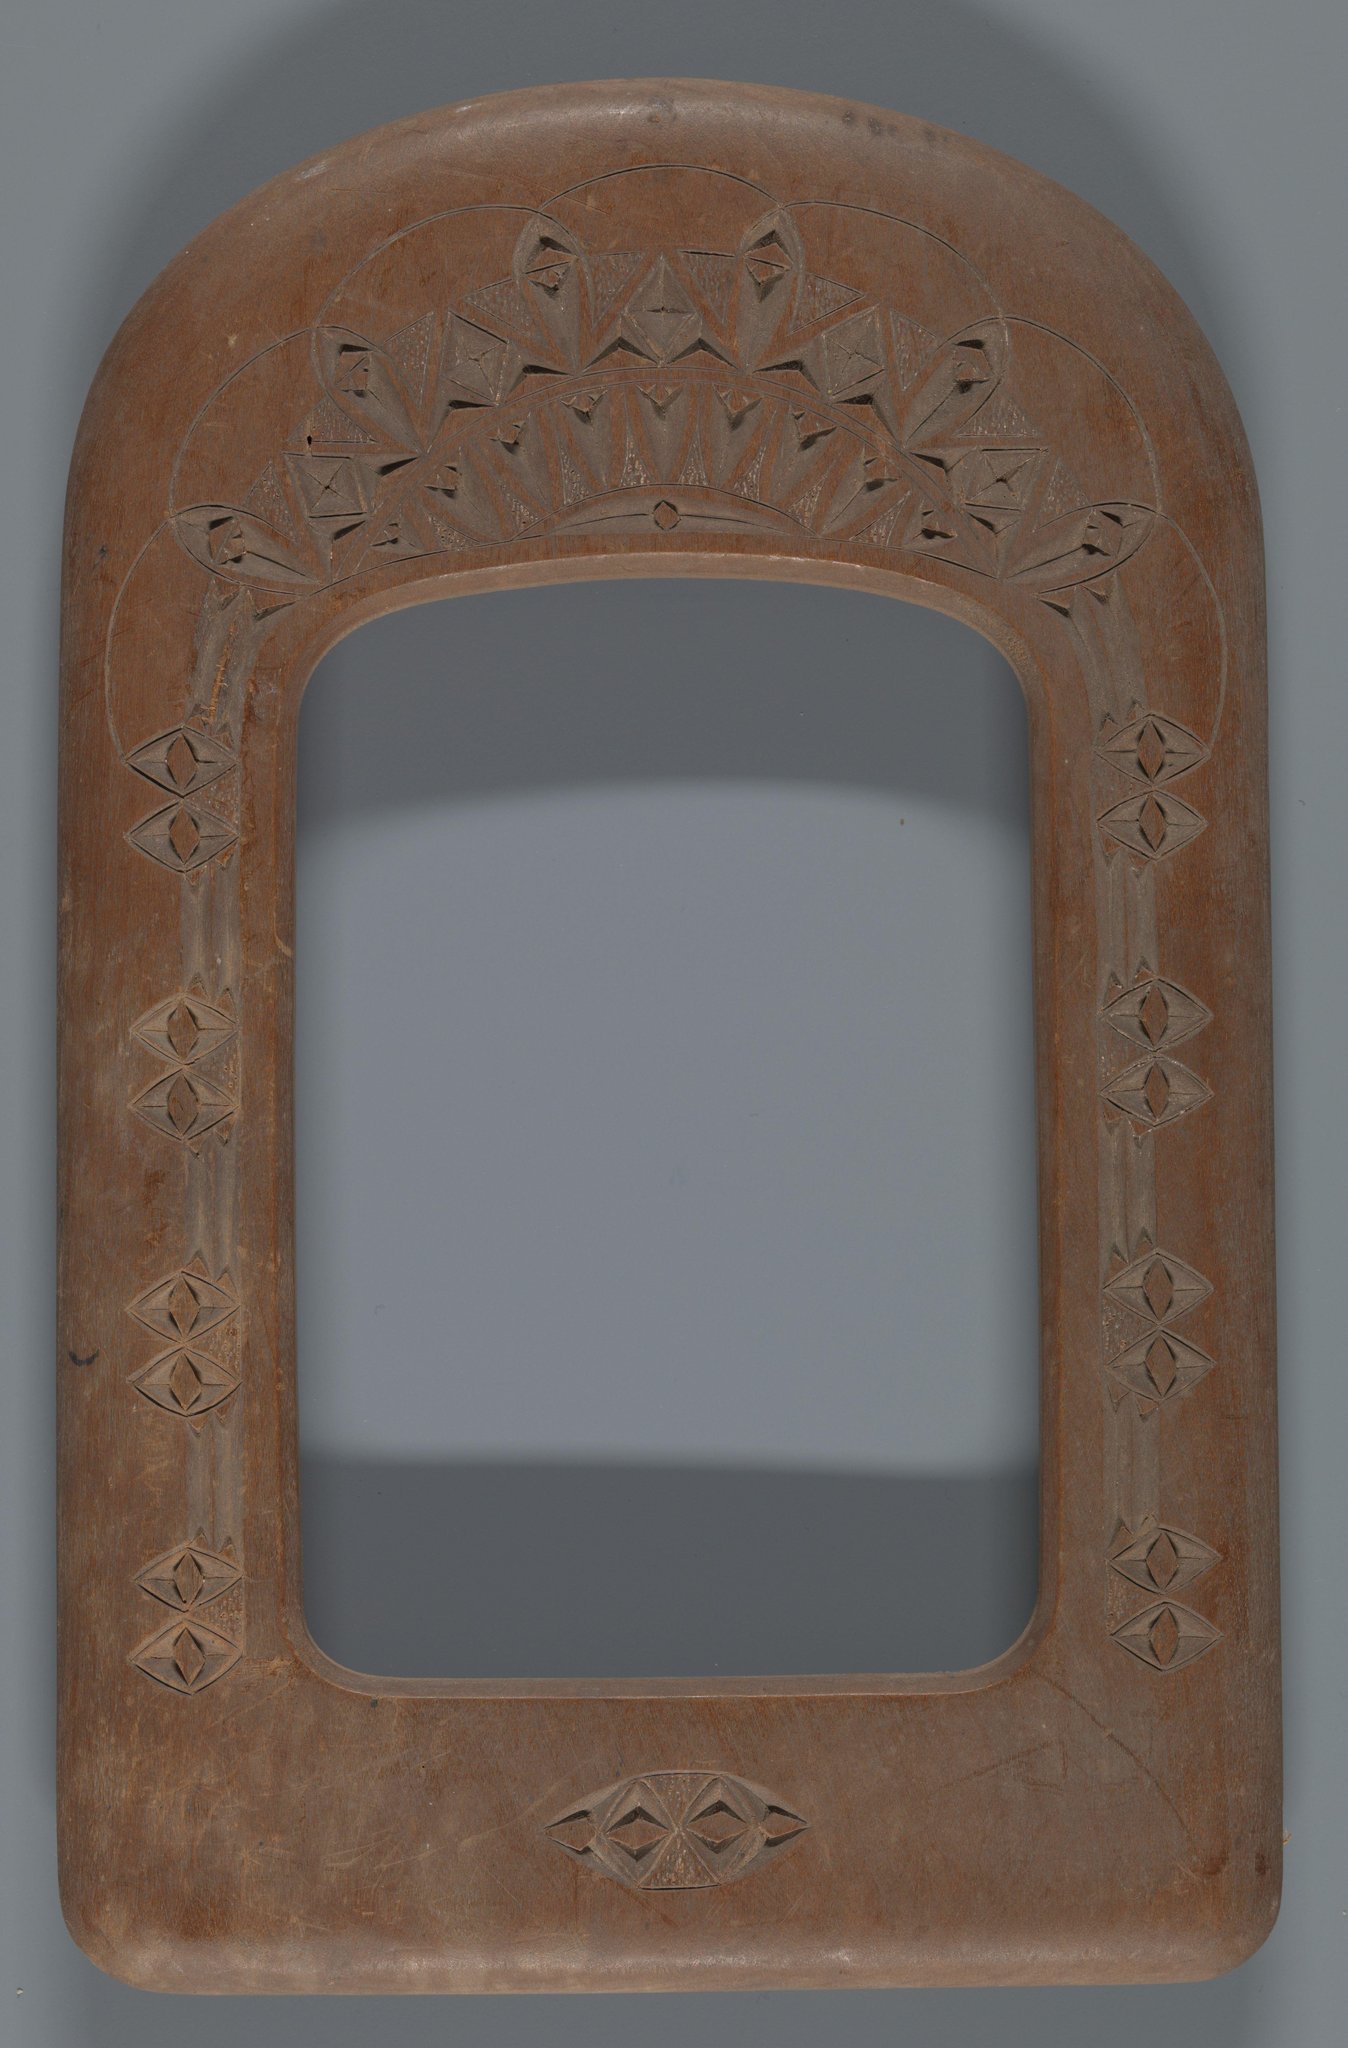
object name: frame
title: Lijst met houtsnijwerk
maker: Anonymous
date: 1880-1920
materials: wood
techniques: cutting